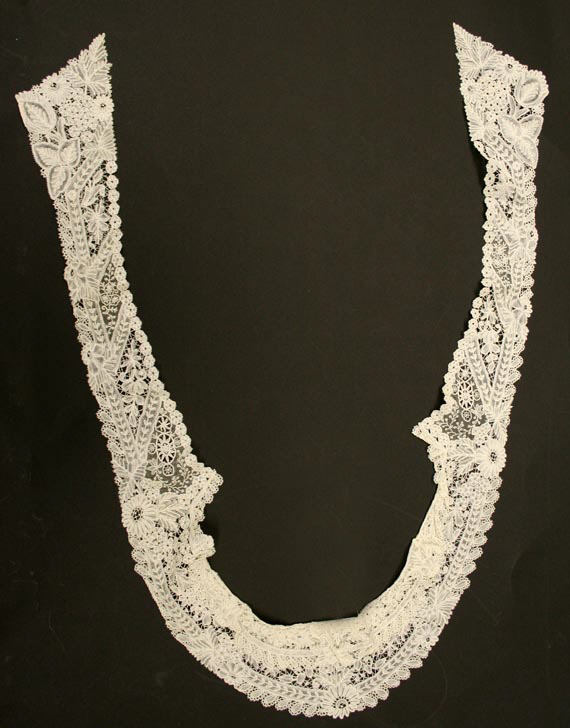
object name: collar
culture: belgian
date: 1890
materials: cotton